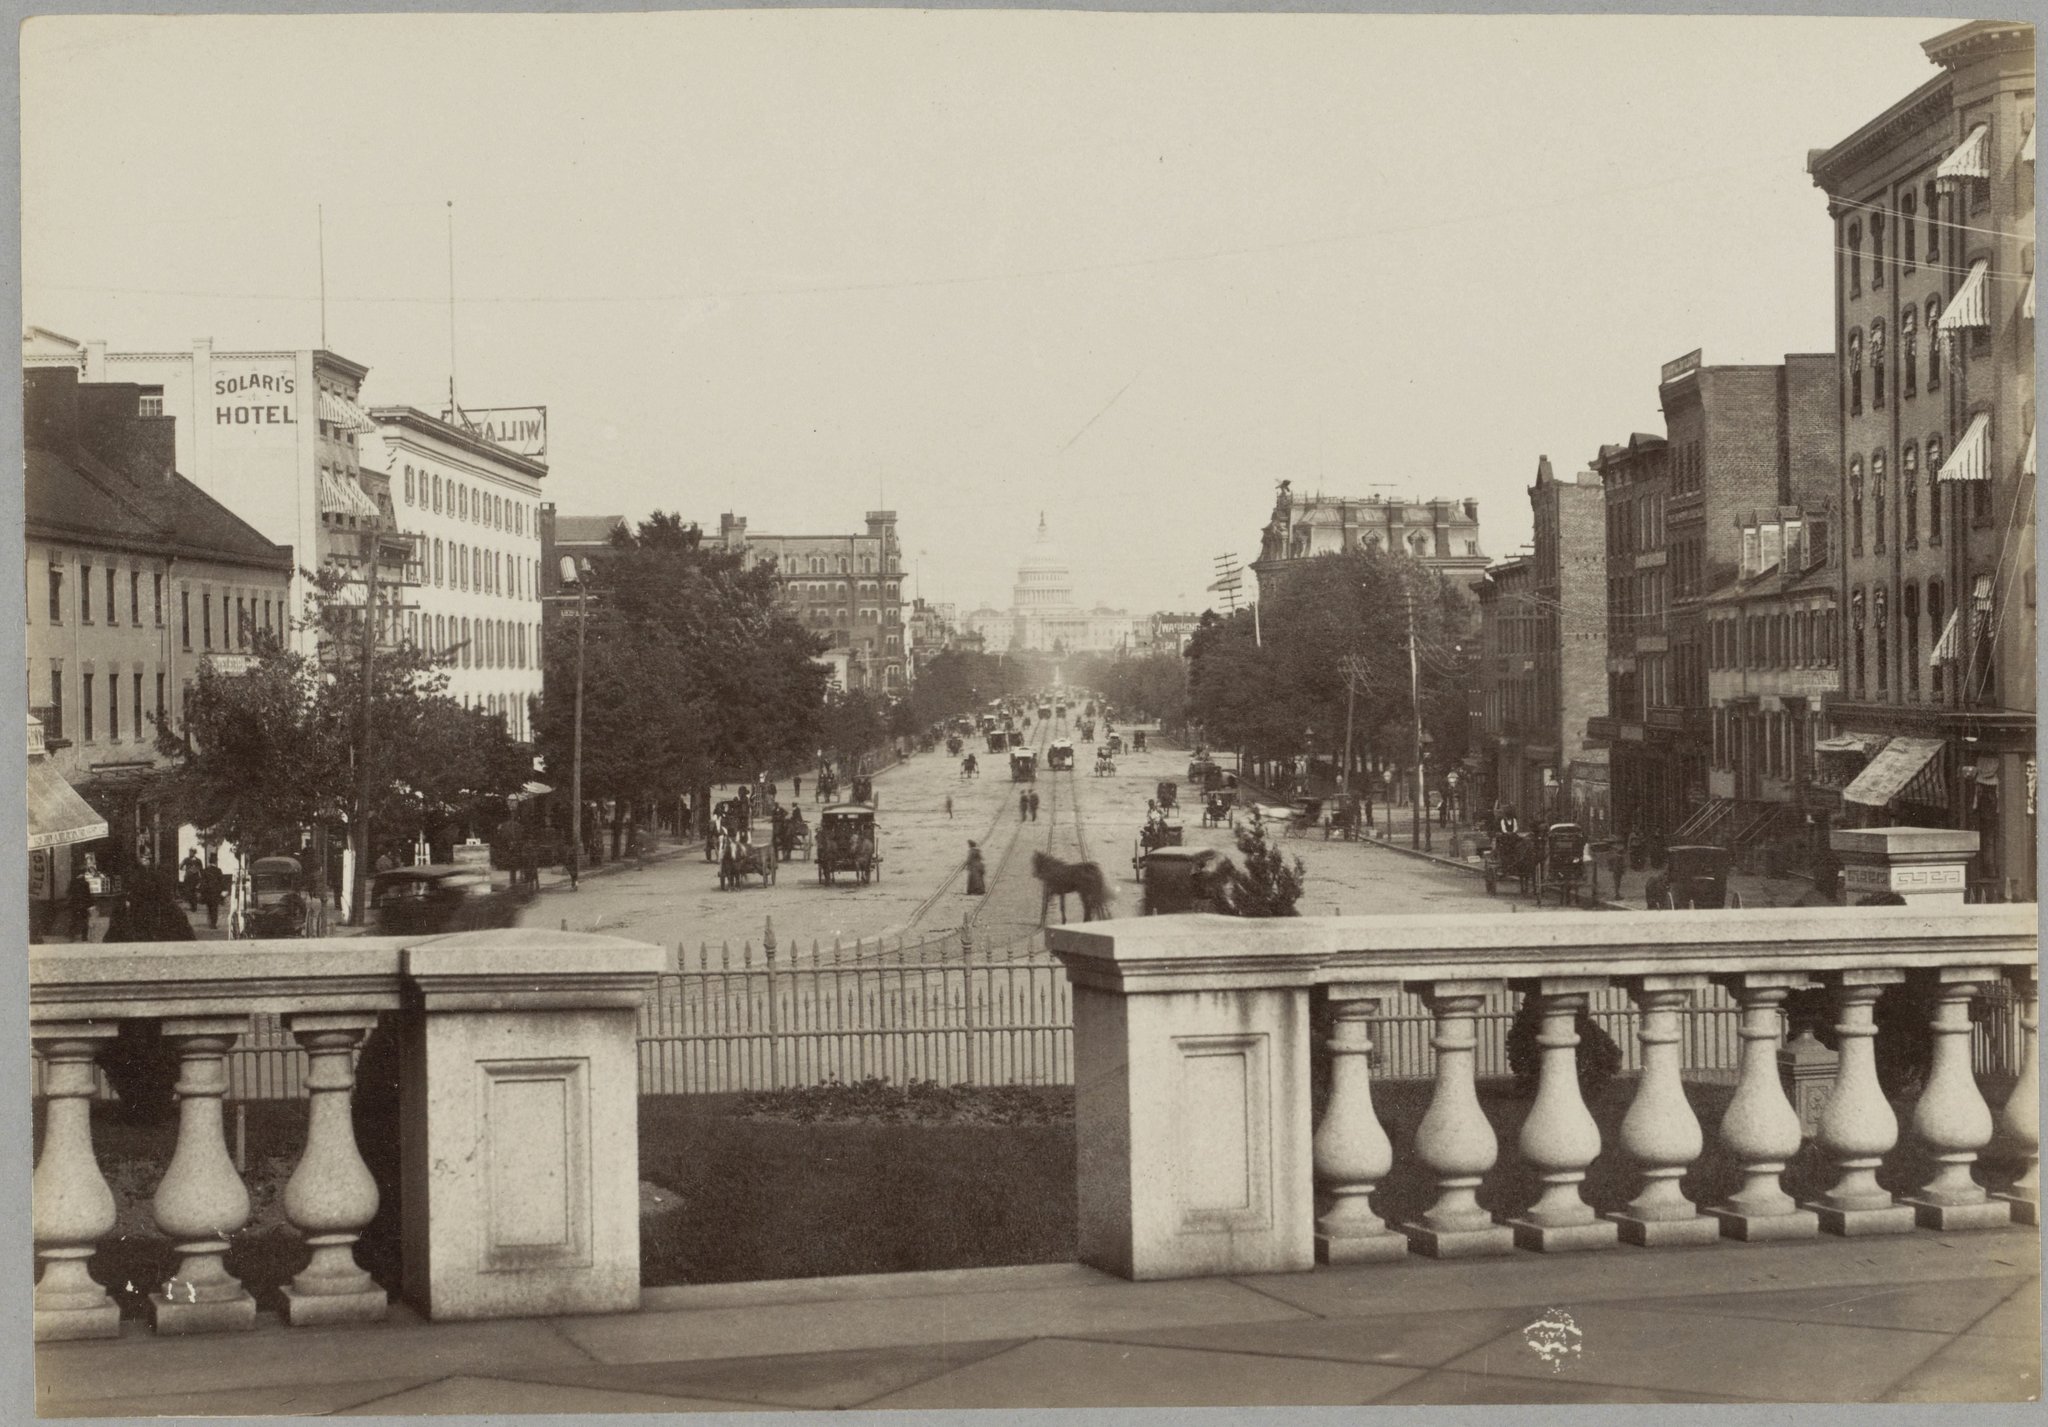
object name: photograph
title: Pennsylvania Avenue in Washington D.C. met aan het einde het Capitool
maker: Anonymous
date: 1880-1900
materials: cardboard, paper, photographic support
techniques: albumen print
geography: washington d.c.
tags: street